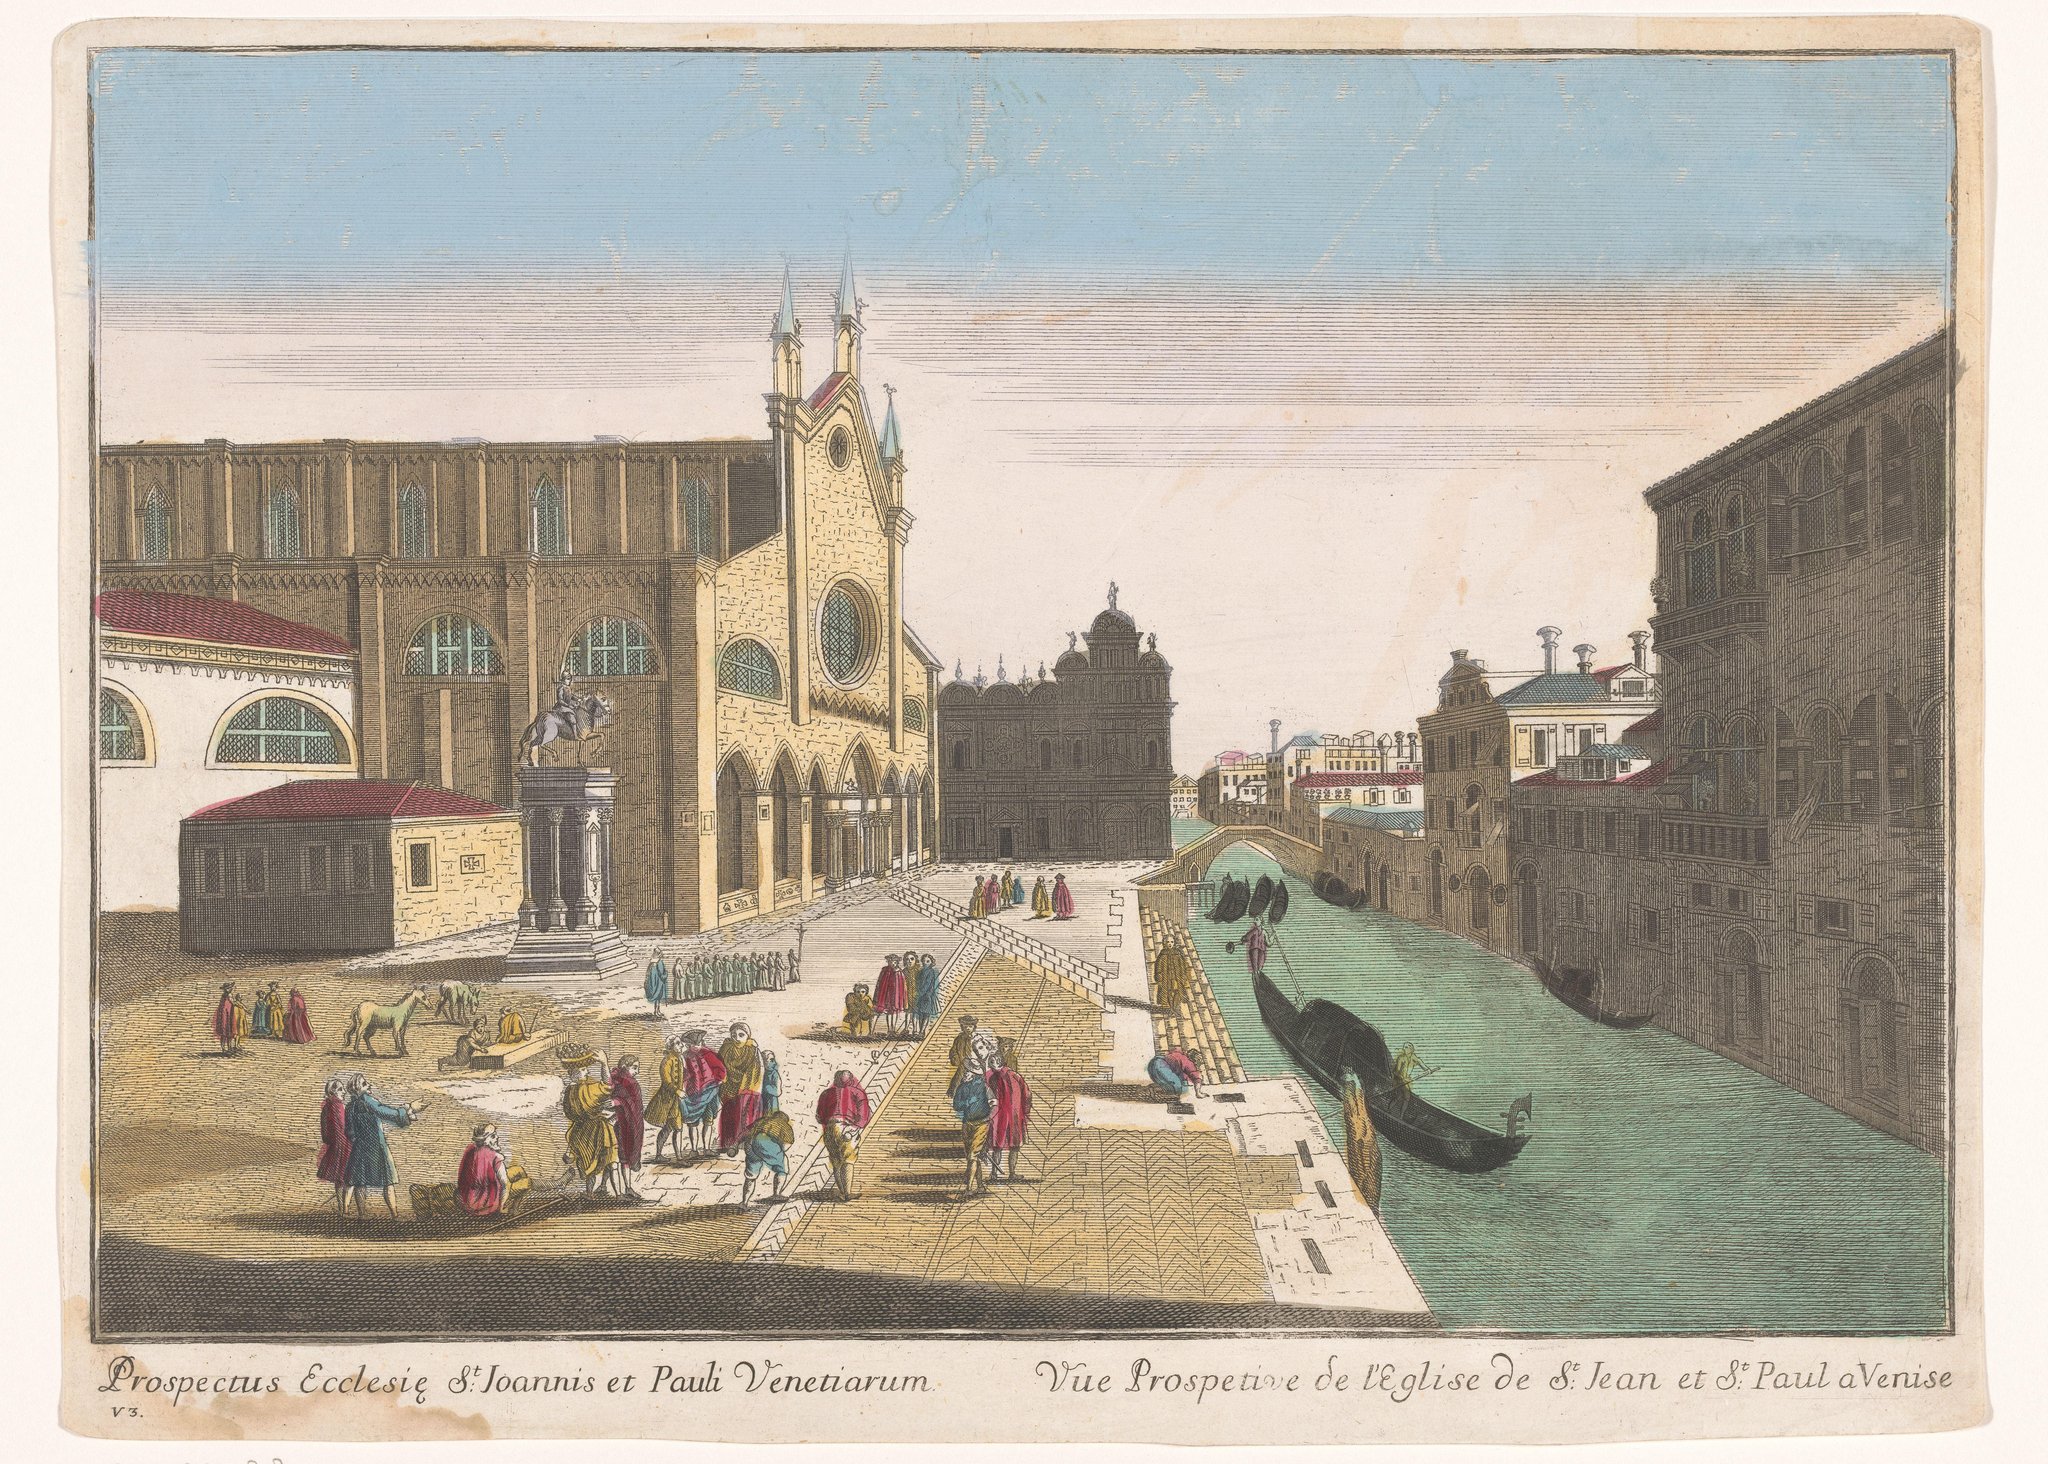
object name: print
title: Prospectus Ecclesie St: Joannis et Pauli Venetiarum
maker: Anonymous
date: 1700-1799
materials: paper, watercolor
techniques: brush, etching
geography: bassano del grappa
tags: santi giovanni e paolo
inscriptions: collector's mark: Lugt 2228